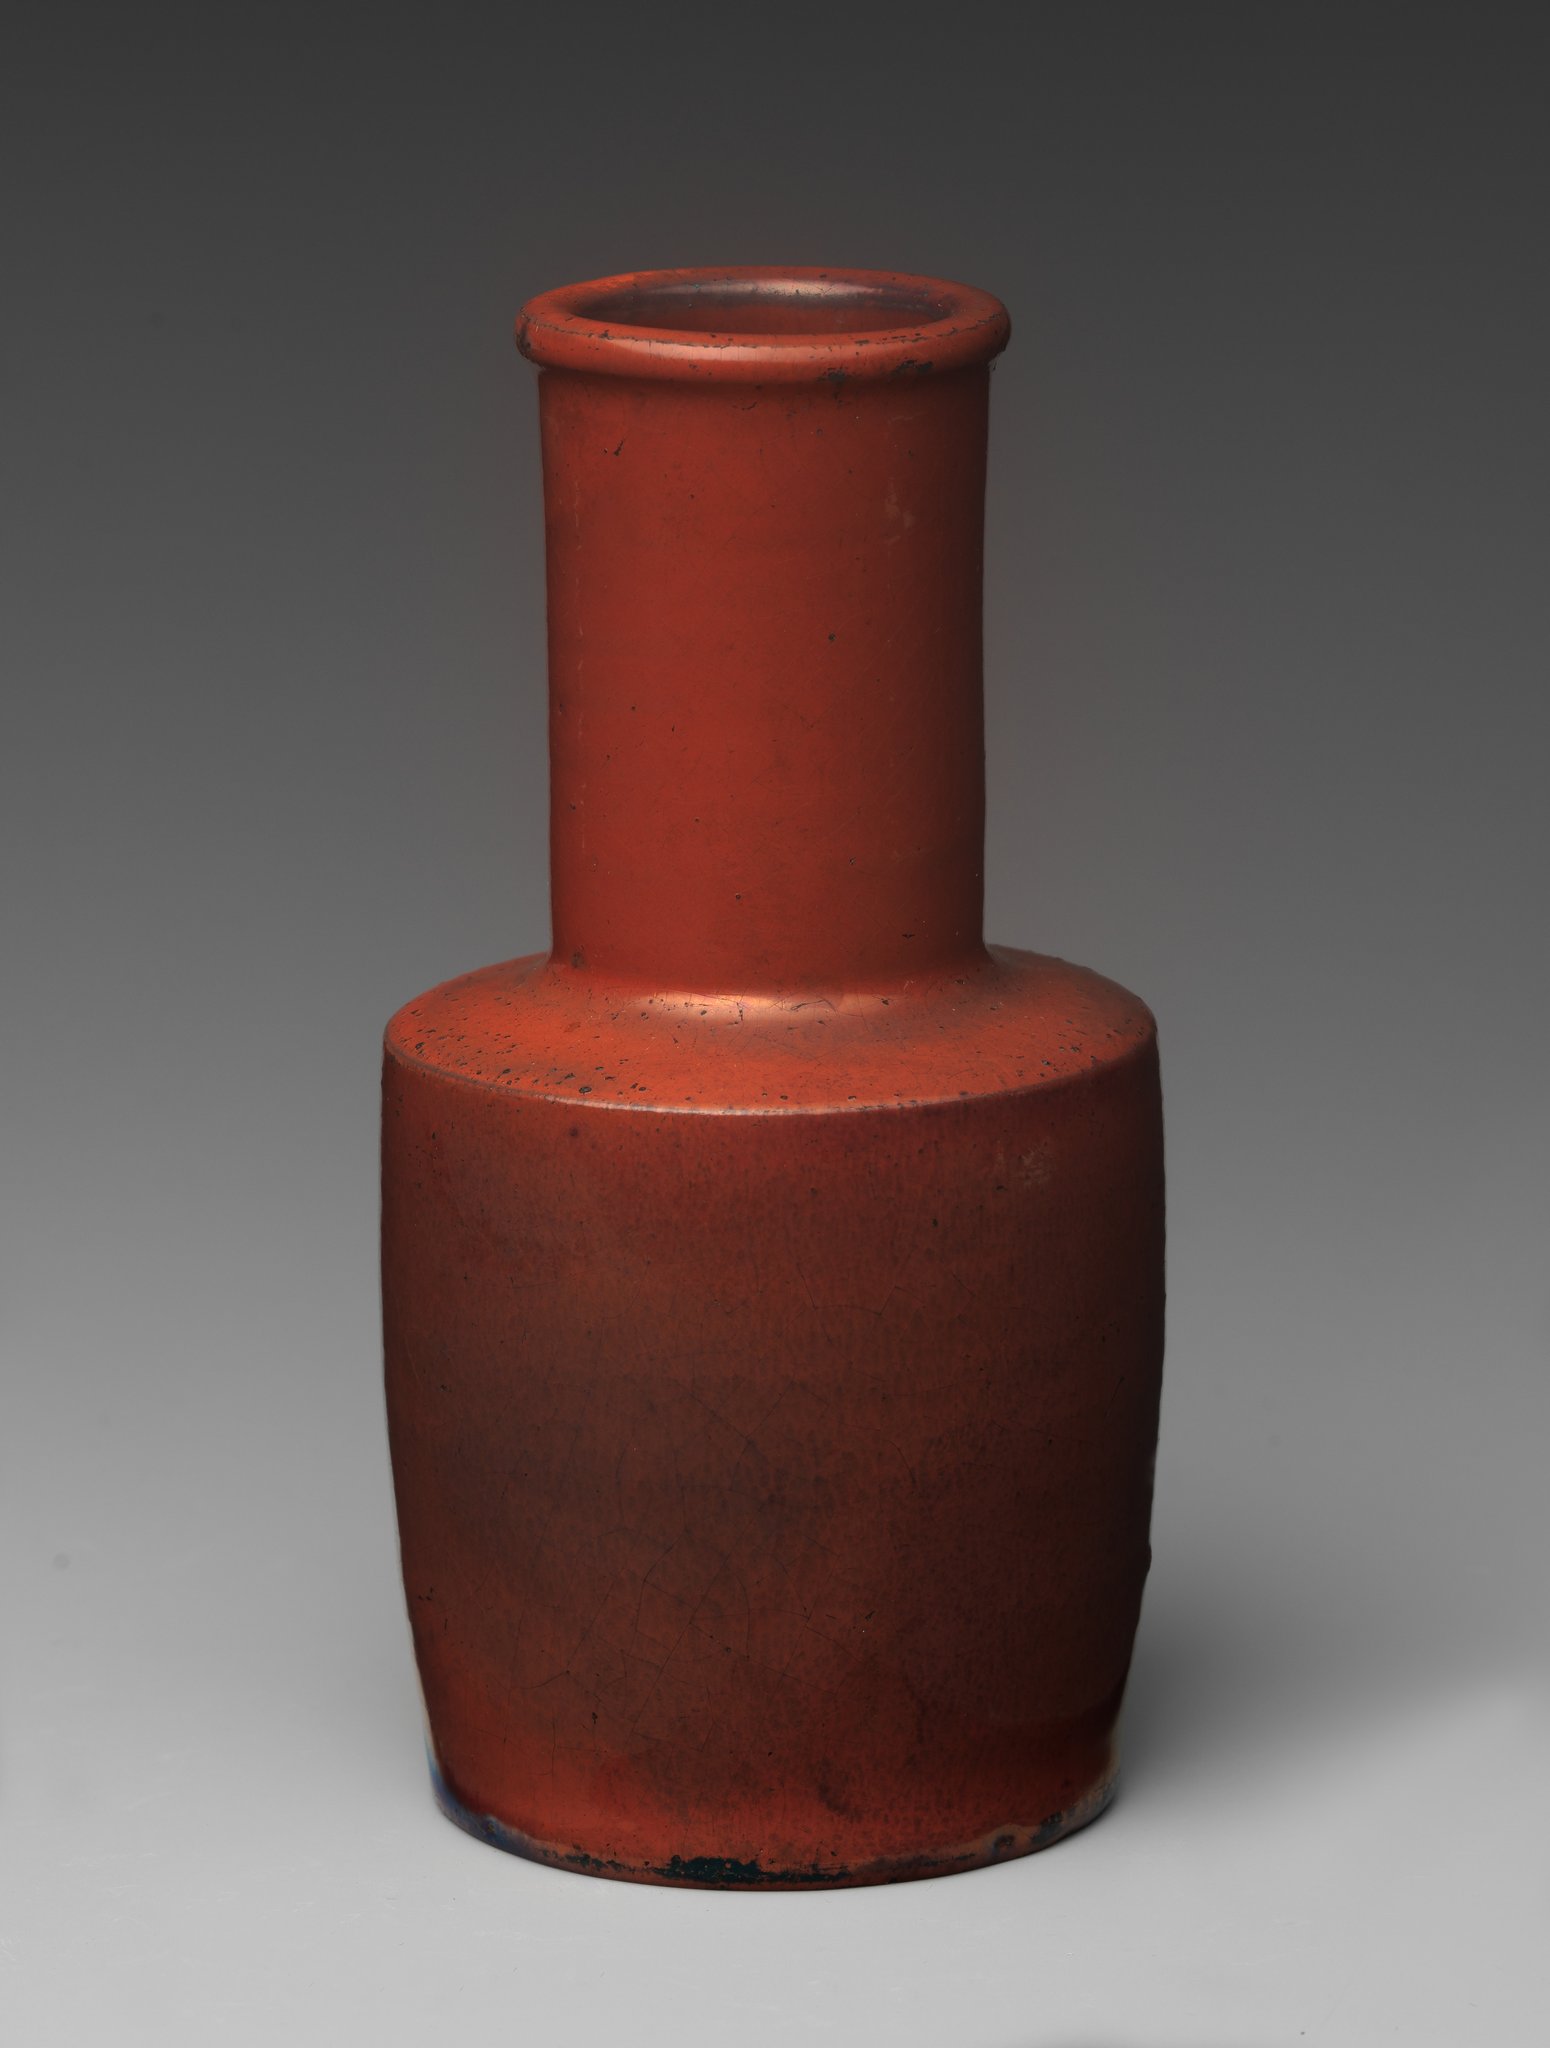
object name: bottle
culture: japanese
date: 1701-1800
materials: clay, glaze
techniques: glazing